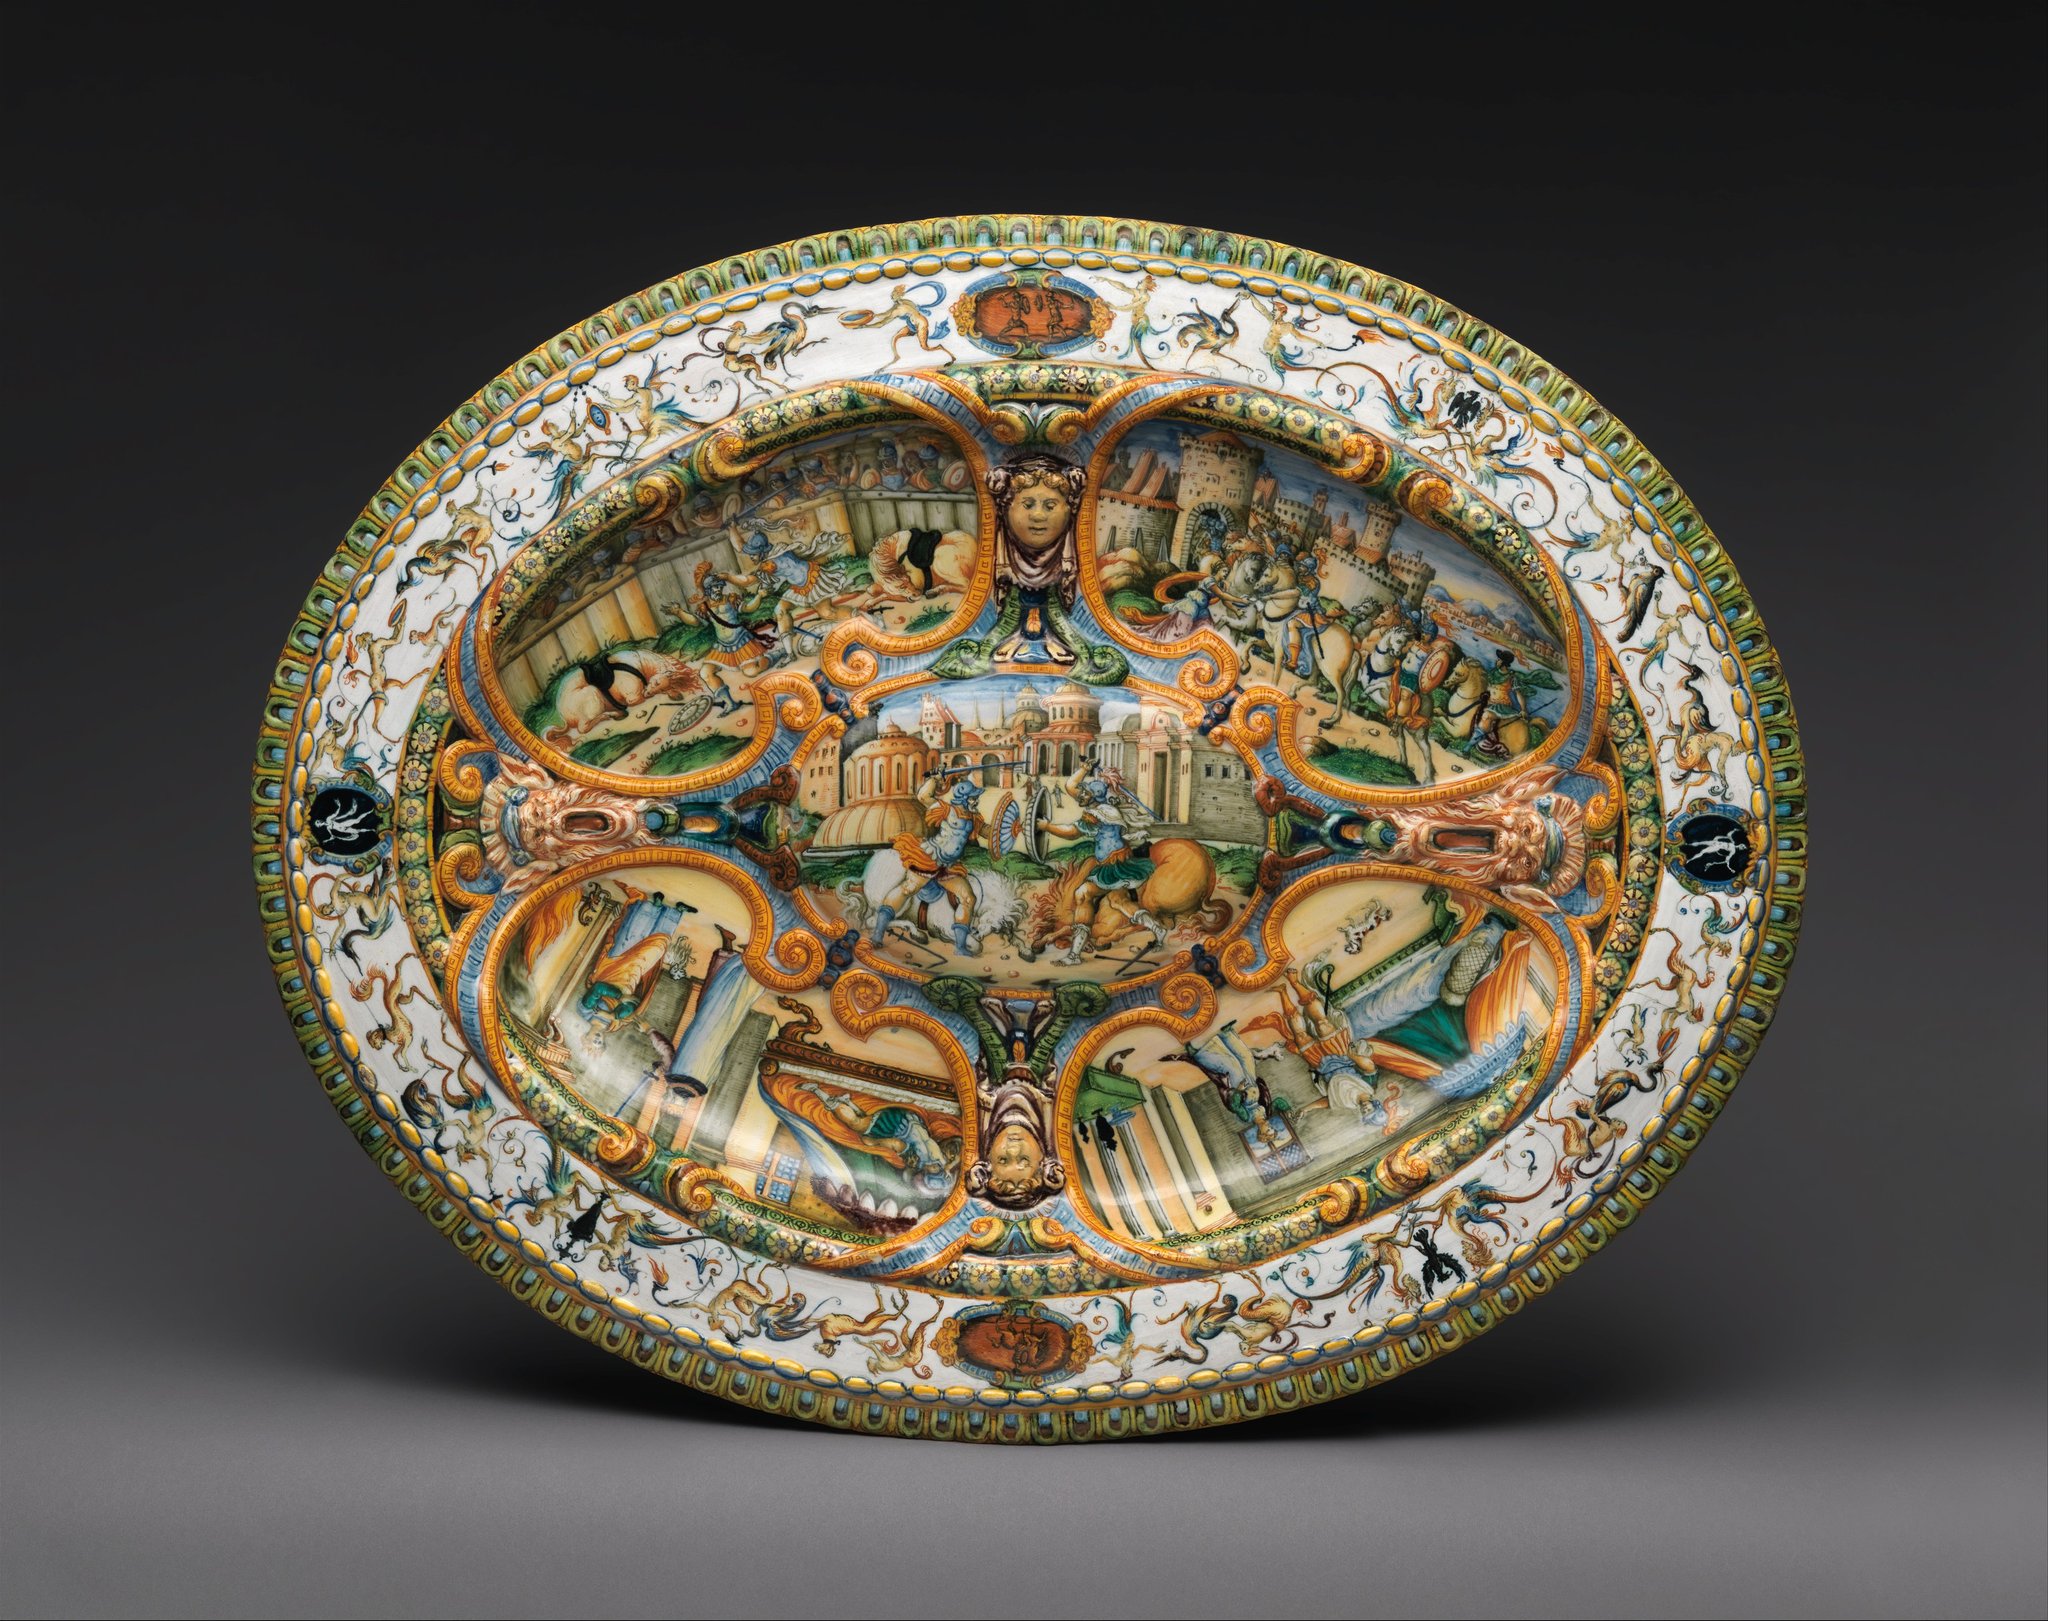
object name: basin or dish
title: Oval basin or dish with subject from Amadis of Gaul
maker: orazio fontana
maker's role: artist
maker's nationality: italian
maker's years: 1505-1576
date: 1559-1564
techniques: maiolica, glazing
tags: animals,men,horses